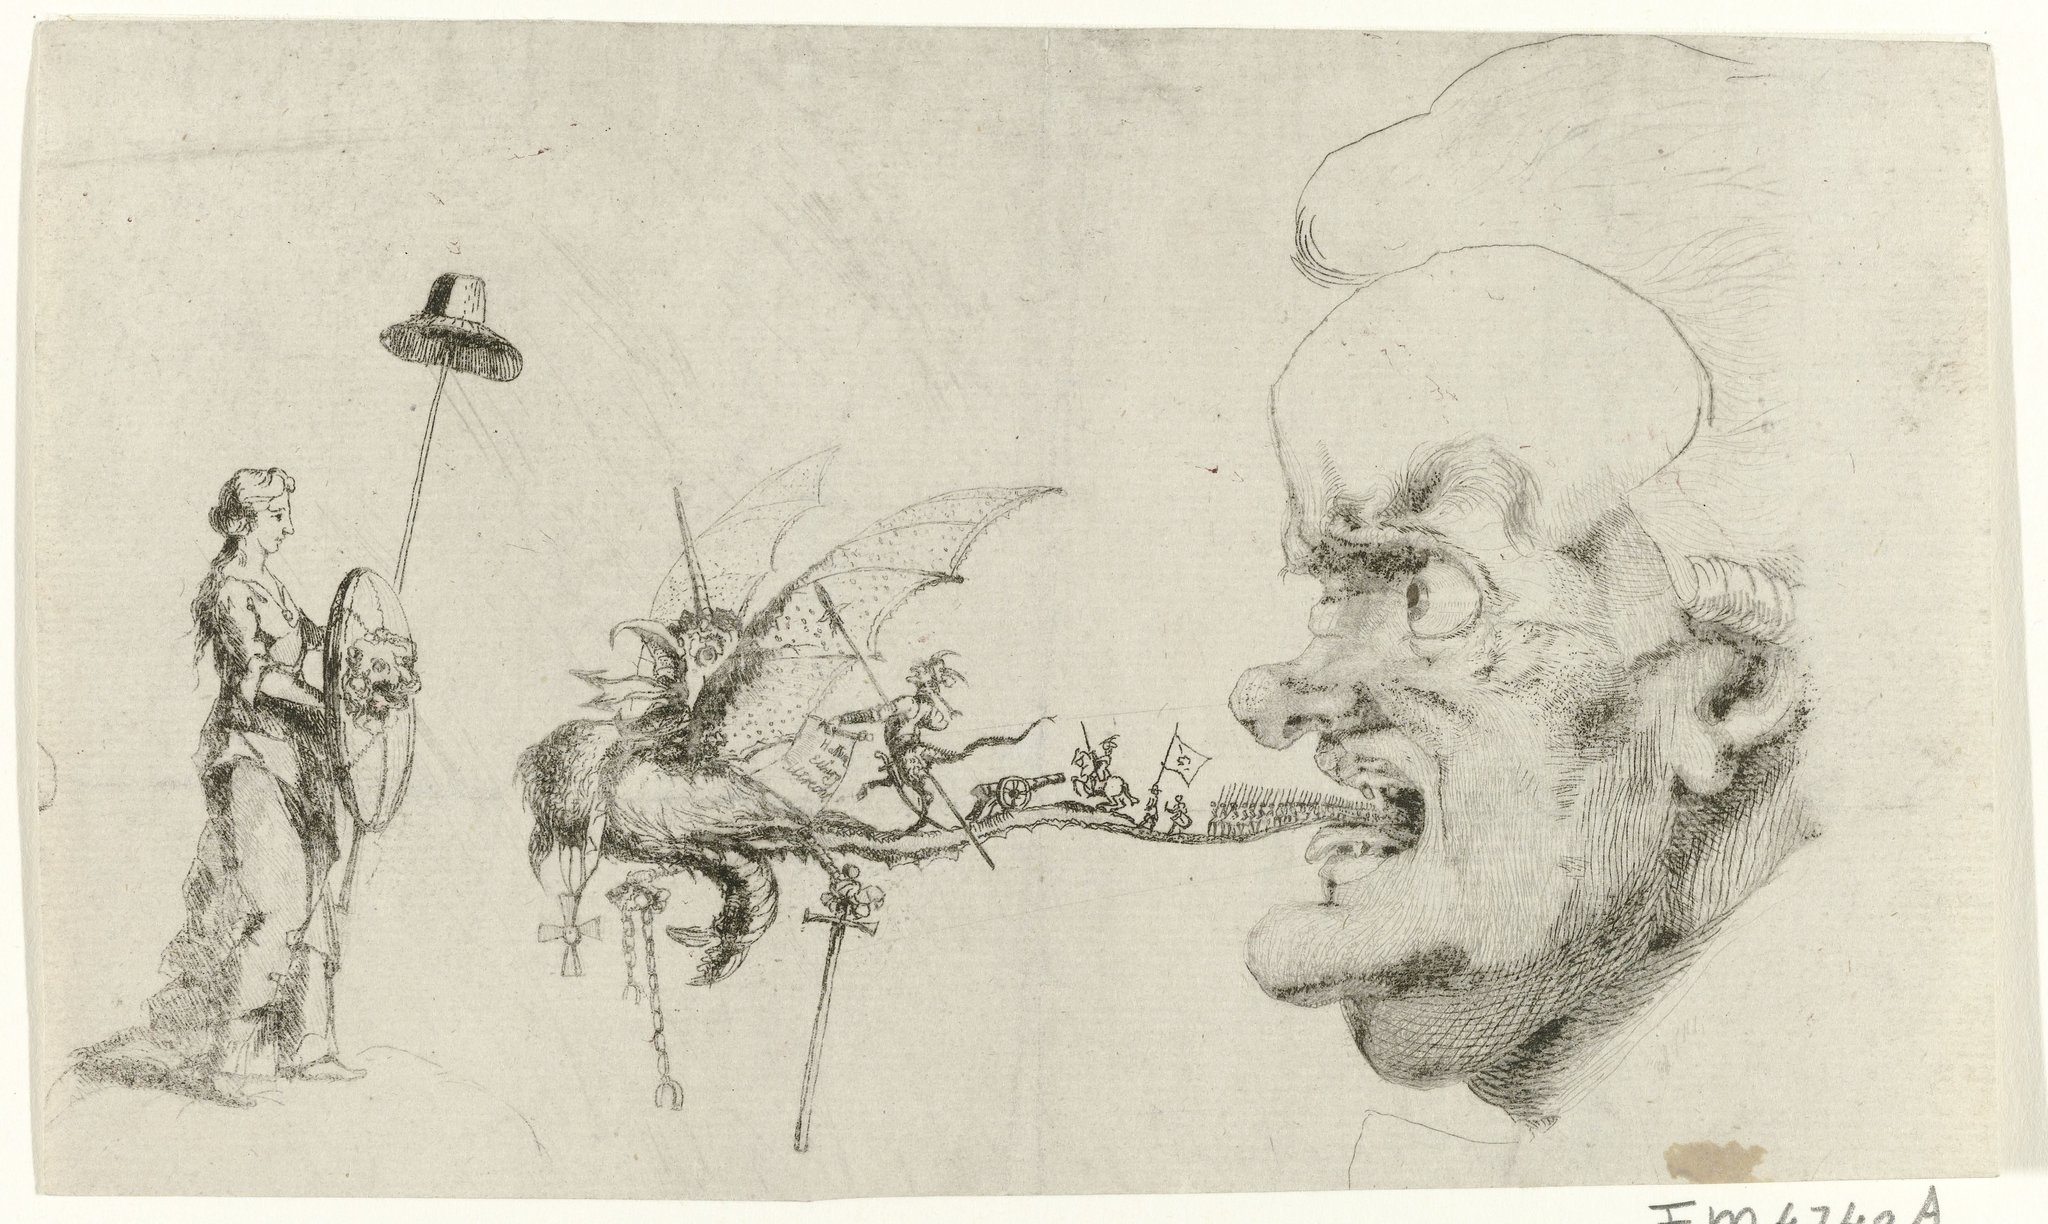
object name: print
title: De Aristocraat, 1786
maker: Anonymous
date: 1786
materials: paper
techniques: drypoint, engraving, etching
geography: northern netherlands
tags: mis-shapen animals; monsters, freedom, liberty; 'libertà' (ripa) (+ abstract concept represented by female figure), patriots (1780-1795)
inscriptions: collector's mark: Lugt 2228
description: Kop van de Aristocraat die een monster en soldaten uitbraakt. Een duivel in deze stoet draagt een papier met de plaatsnamen Hattem, Elburg, Utrecht. Tegenover het uitbraaksel van de Aristocraat staat de maagd van de Nederlandse Vrijheid met schild, speer en vrijheidshoed. Voorstudie voor de allegorie met de tegenstelling tussen de oude Aristocraat en de jonge Vriend des Volks, 1786.